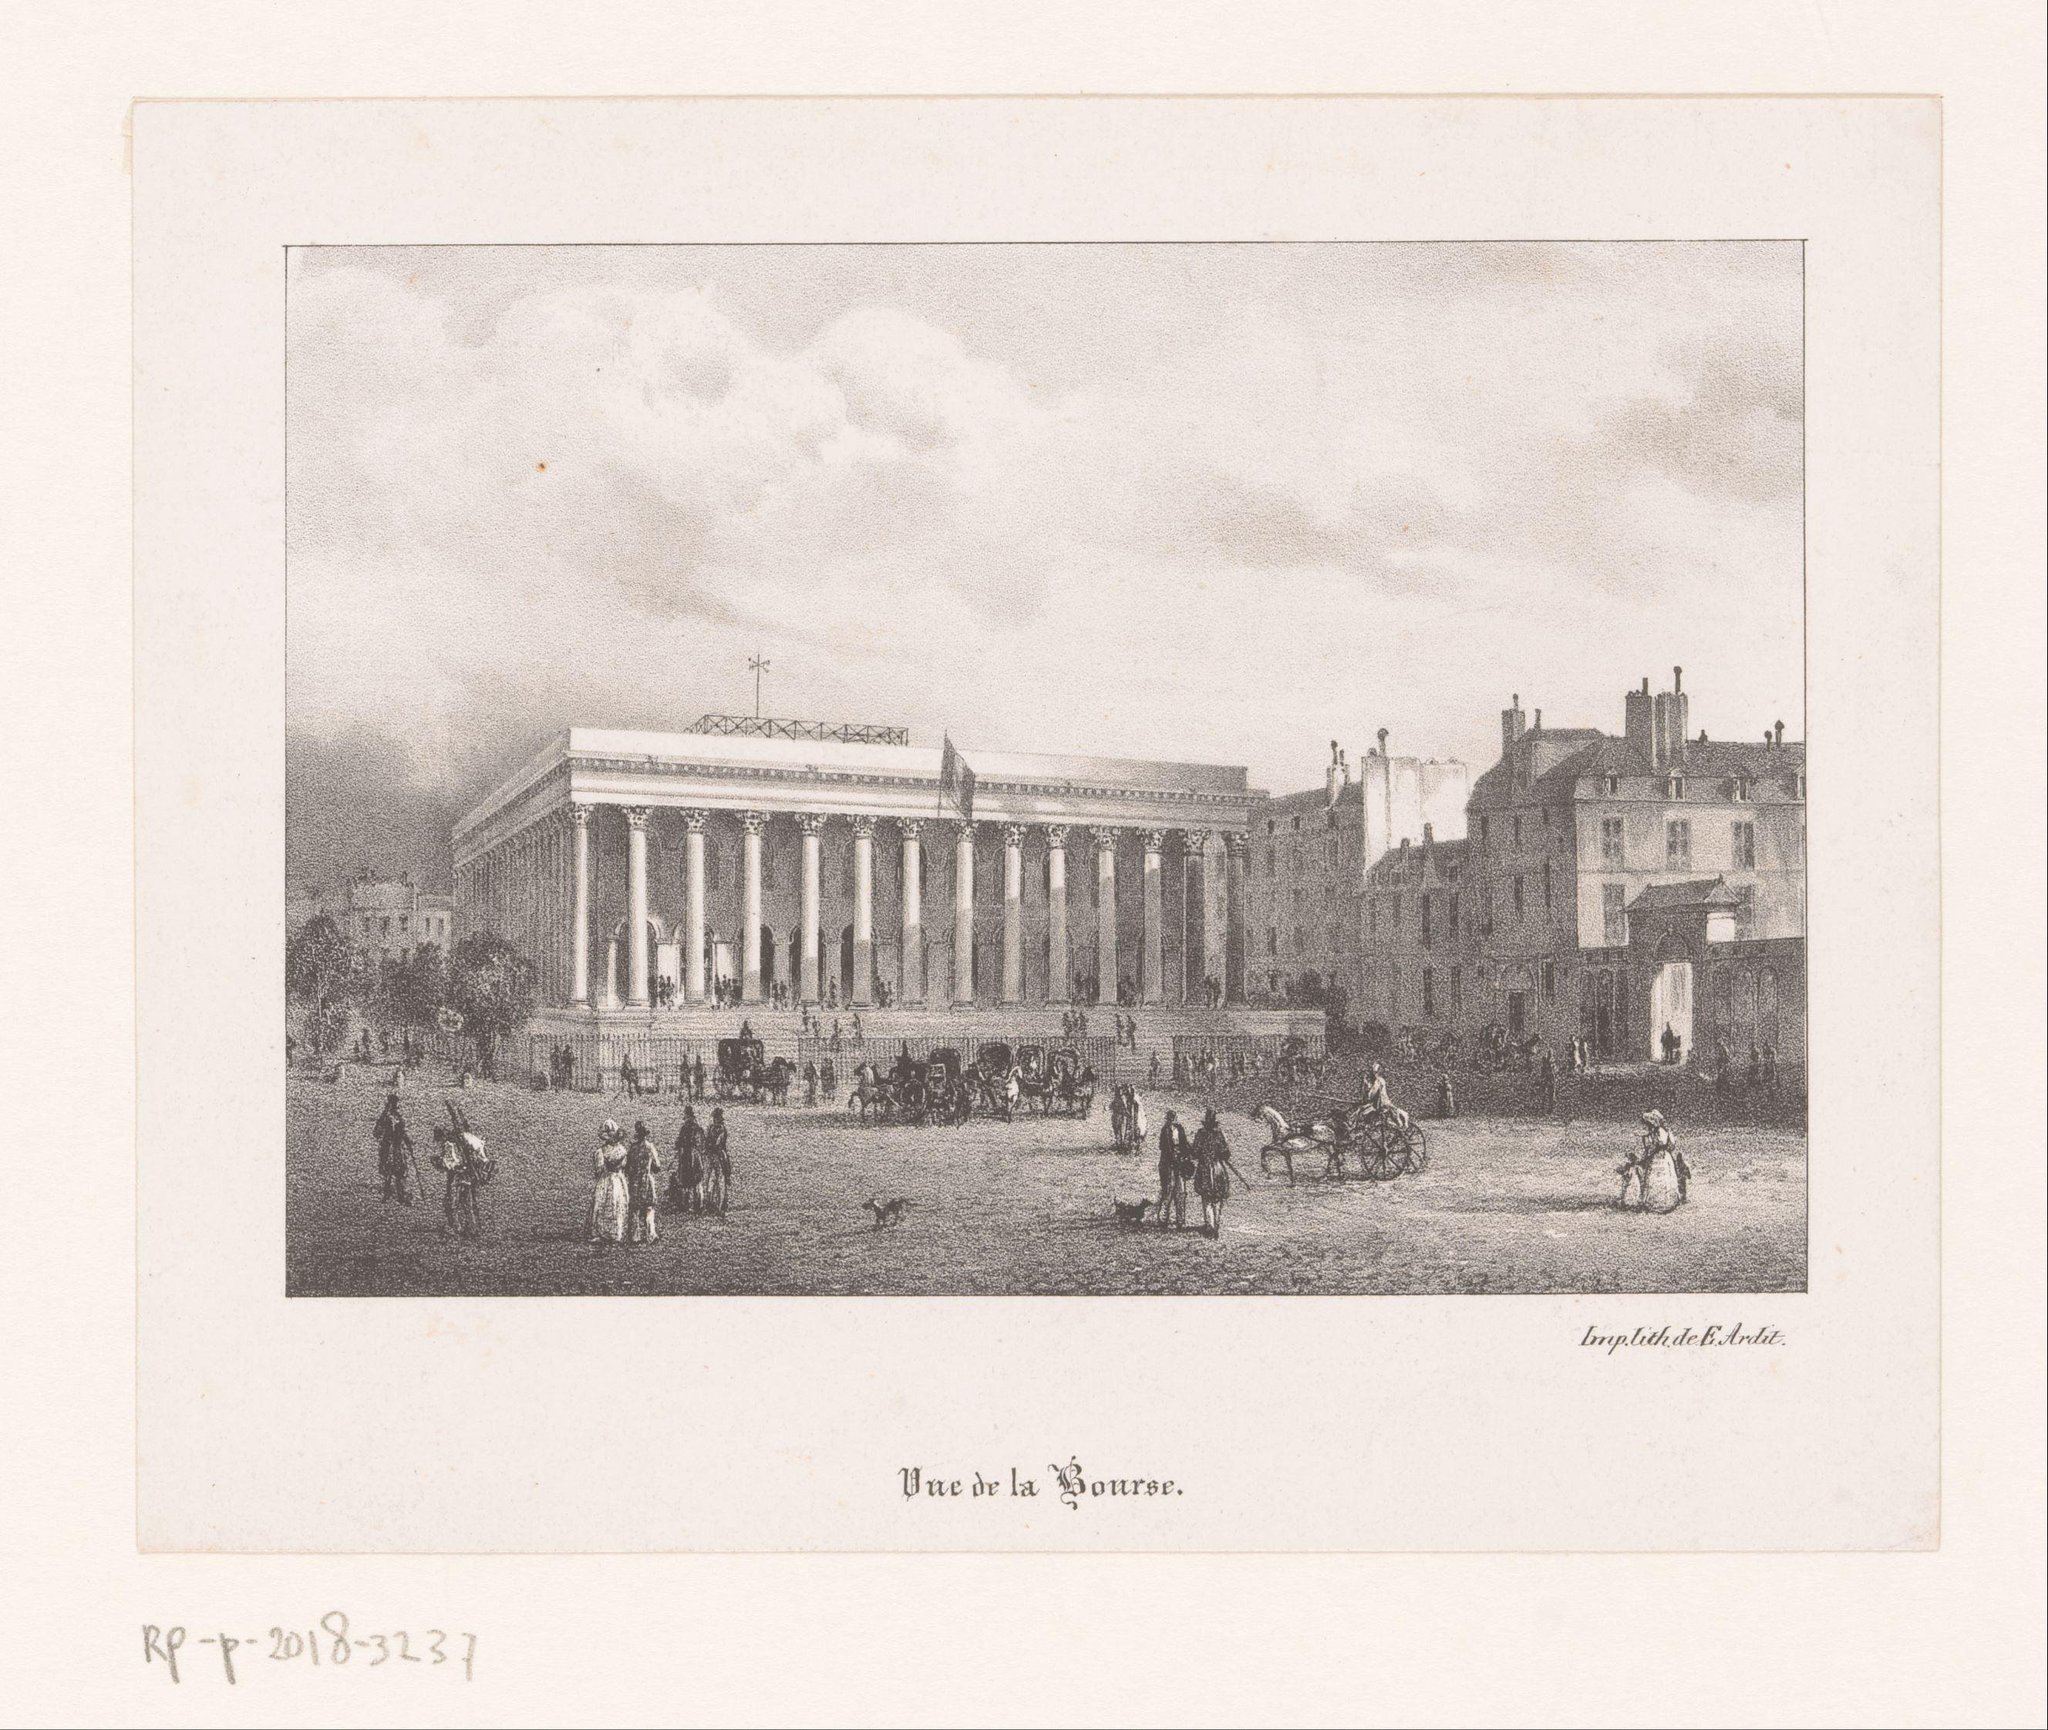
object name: print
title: Gezicht op het beursgebouw te Parijs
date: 1828-1834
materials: paper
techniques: lithograph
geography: france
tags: stock exchange, stock-market, representation of real building (either existing or having existed), paris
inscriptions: collector's mark: Lugt 2228